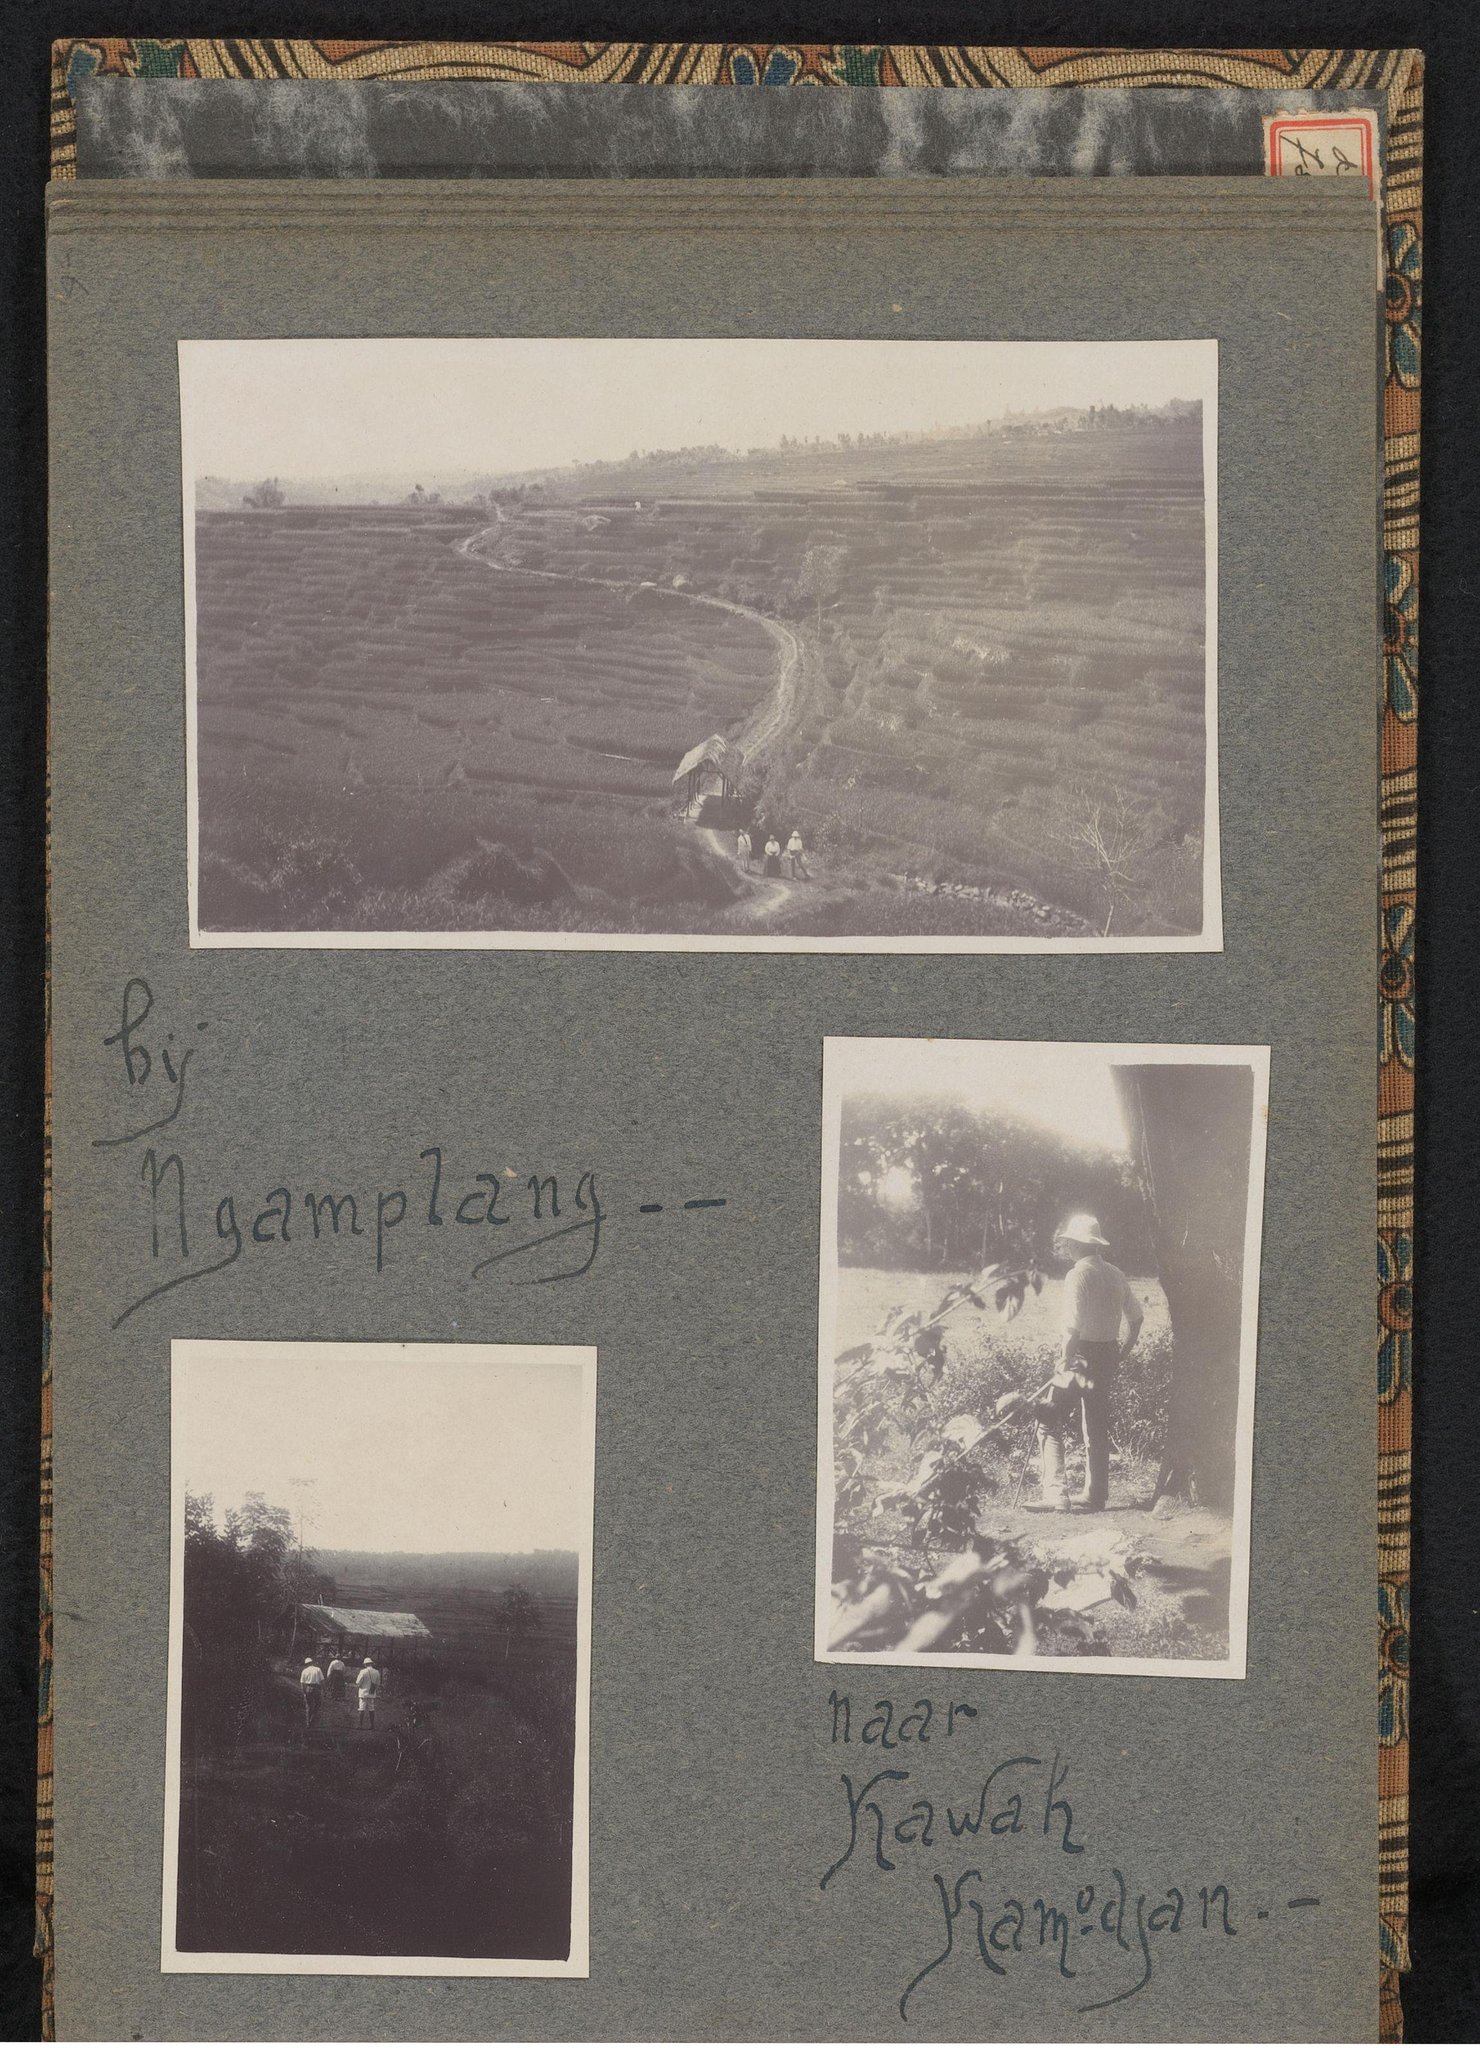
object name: album leaf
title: Arendina van den Berg met haar twee zoons tussen Ngamplang, Garut en de Kawah Kamojang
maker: karel frederik van den berg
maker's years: 1873-1948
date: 1921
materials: paper, cardboard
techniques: gelatin silver print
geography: west java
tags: norbert van den berg (1901-1972), amsterdam, willem jacob van den berg, arendina charlotte marie van den berg-geertsema, mother and son(s) (family group), jungle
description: Deze foto's zijn onderdeel van een album.